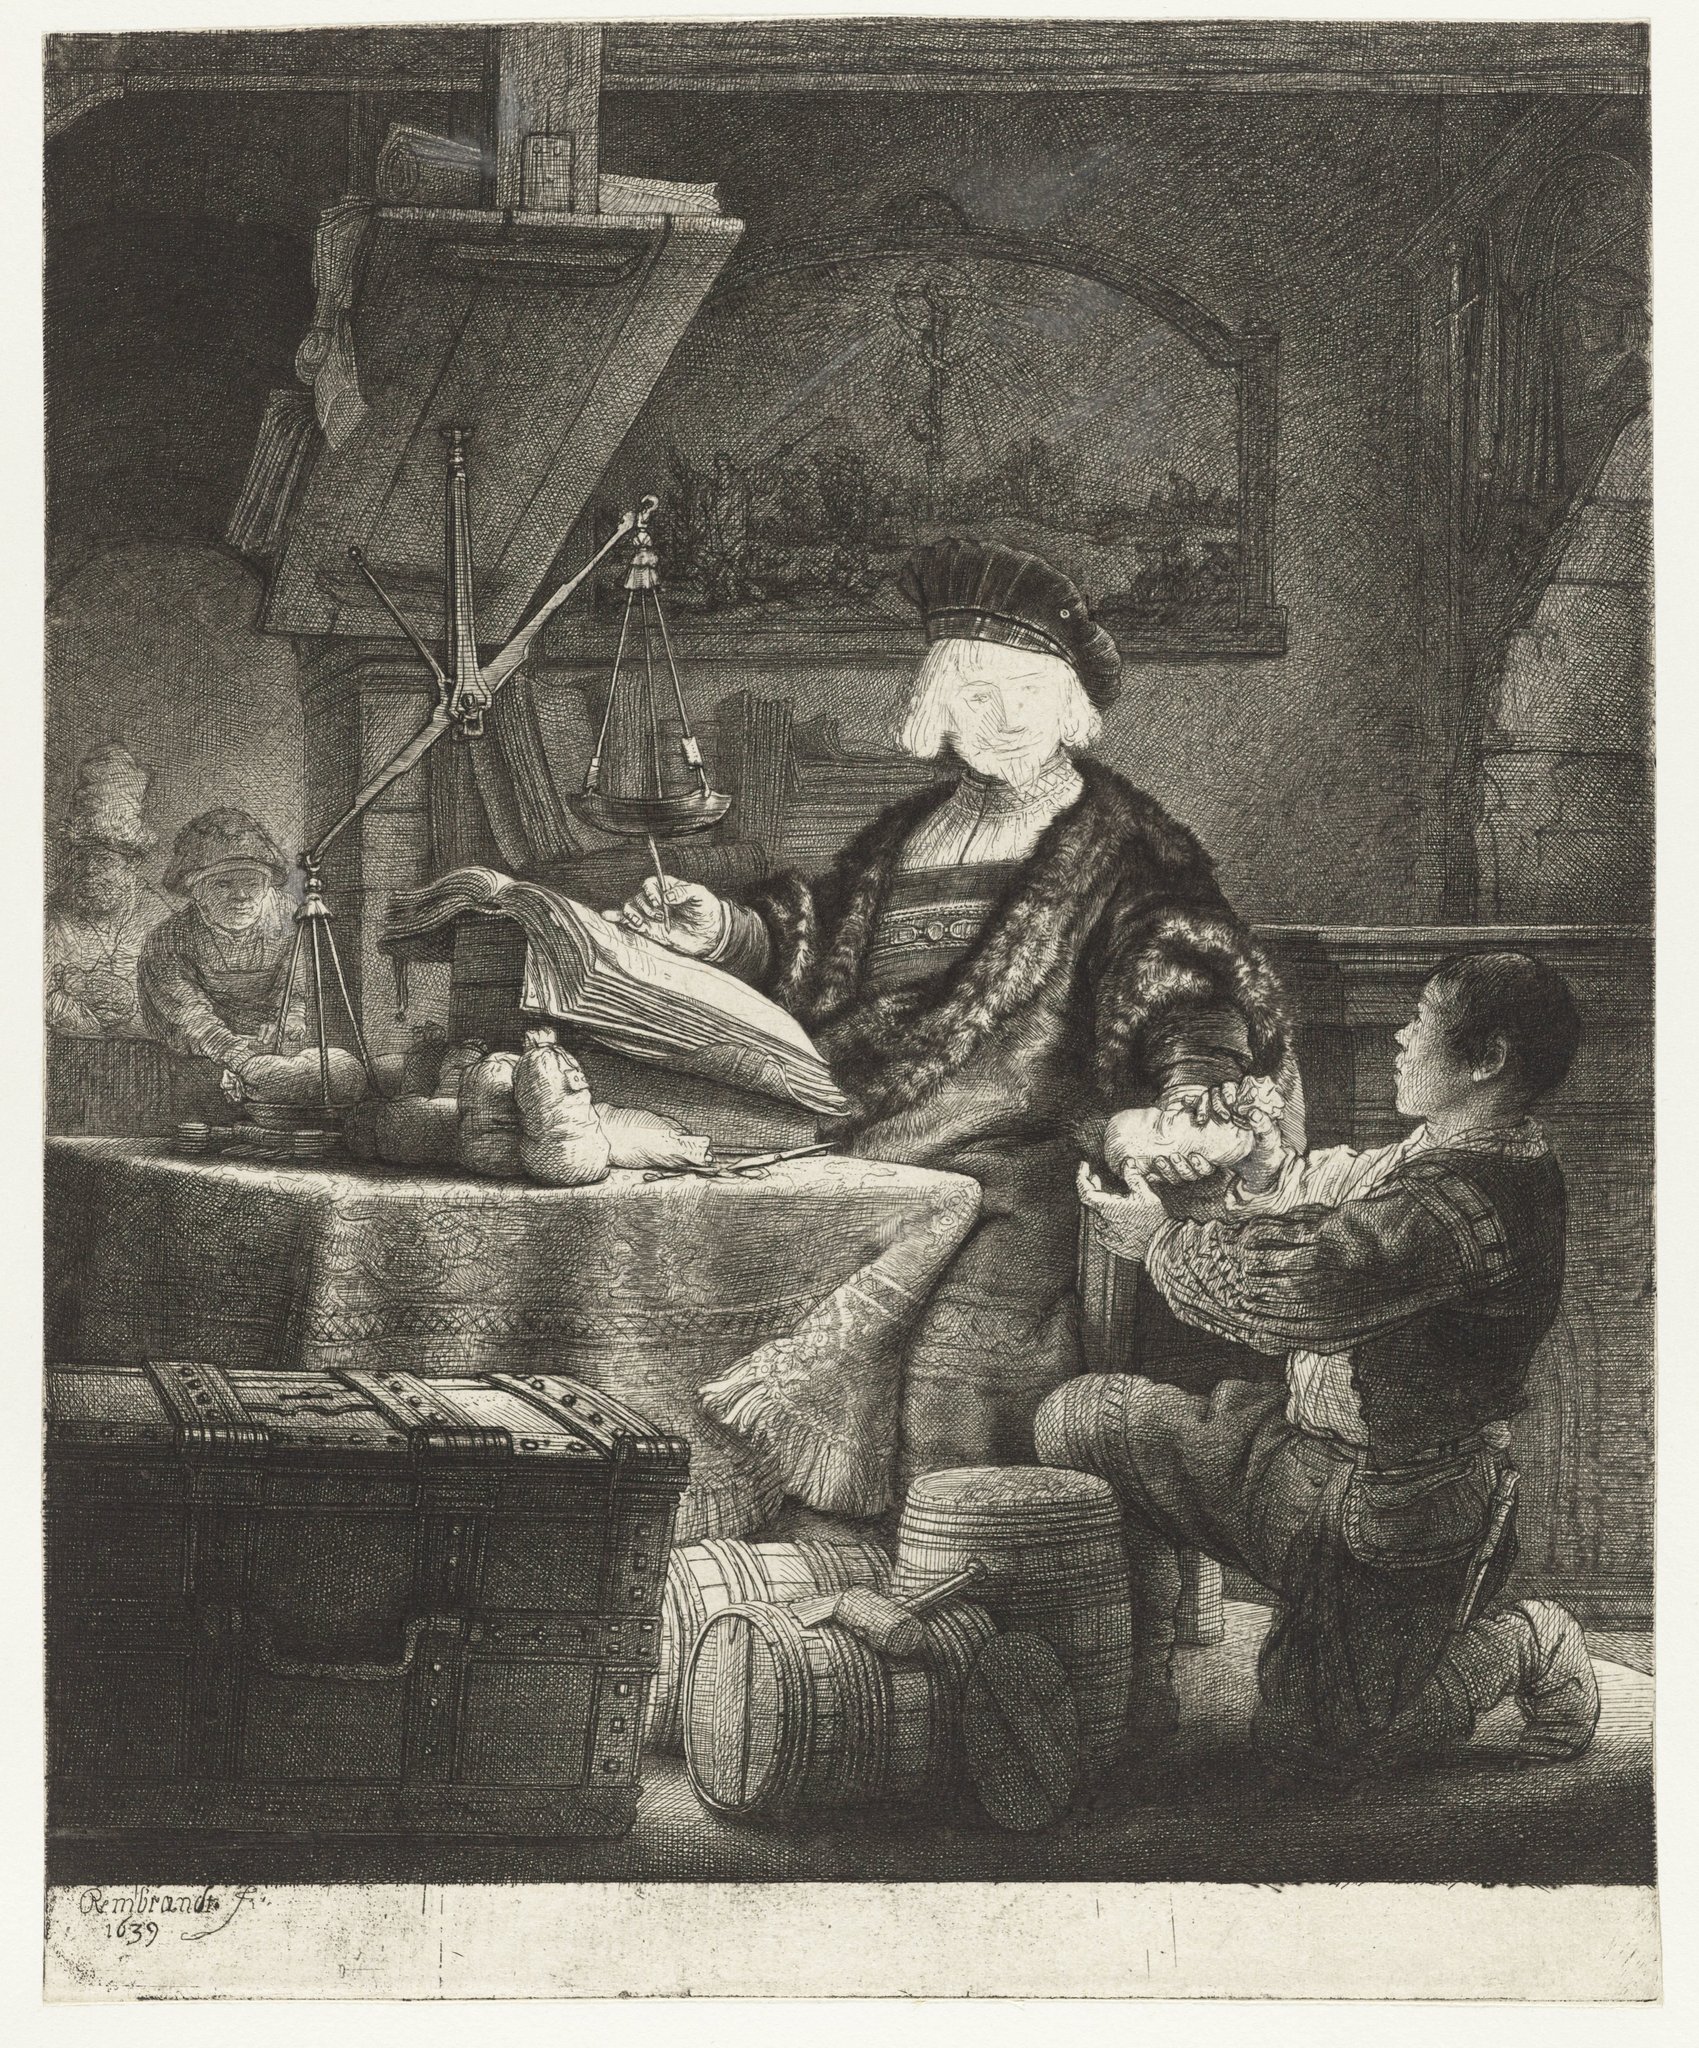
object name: print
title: The Goldweigher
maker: rembrandt van rijn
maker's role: draughtsman, painter, print maker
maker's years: 1606-1669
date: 1639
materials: chalk, paper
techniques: drypoint, etching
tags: amsterdam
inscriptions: signature and date: ‘Rembrandt f. 1639’, mark: Lugt 240